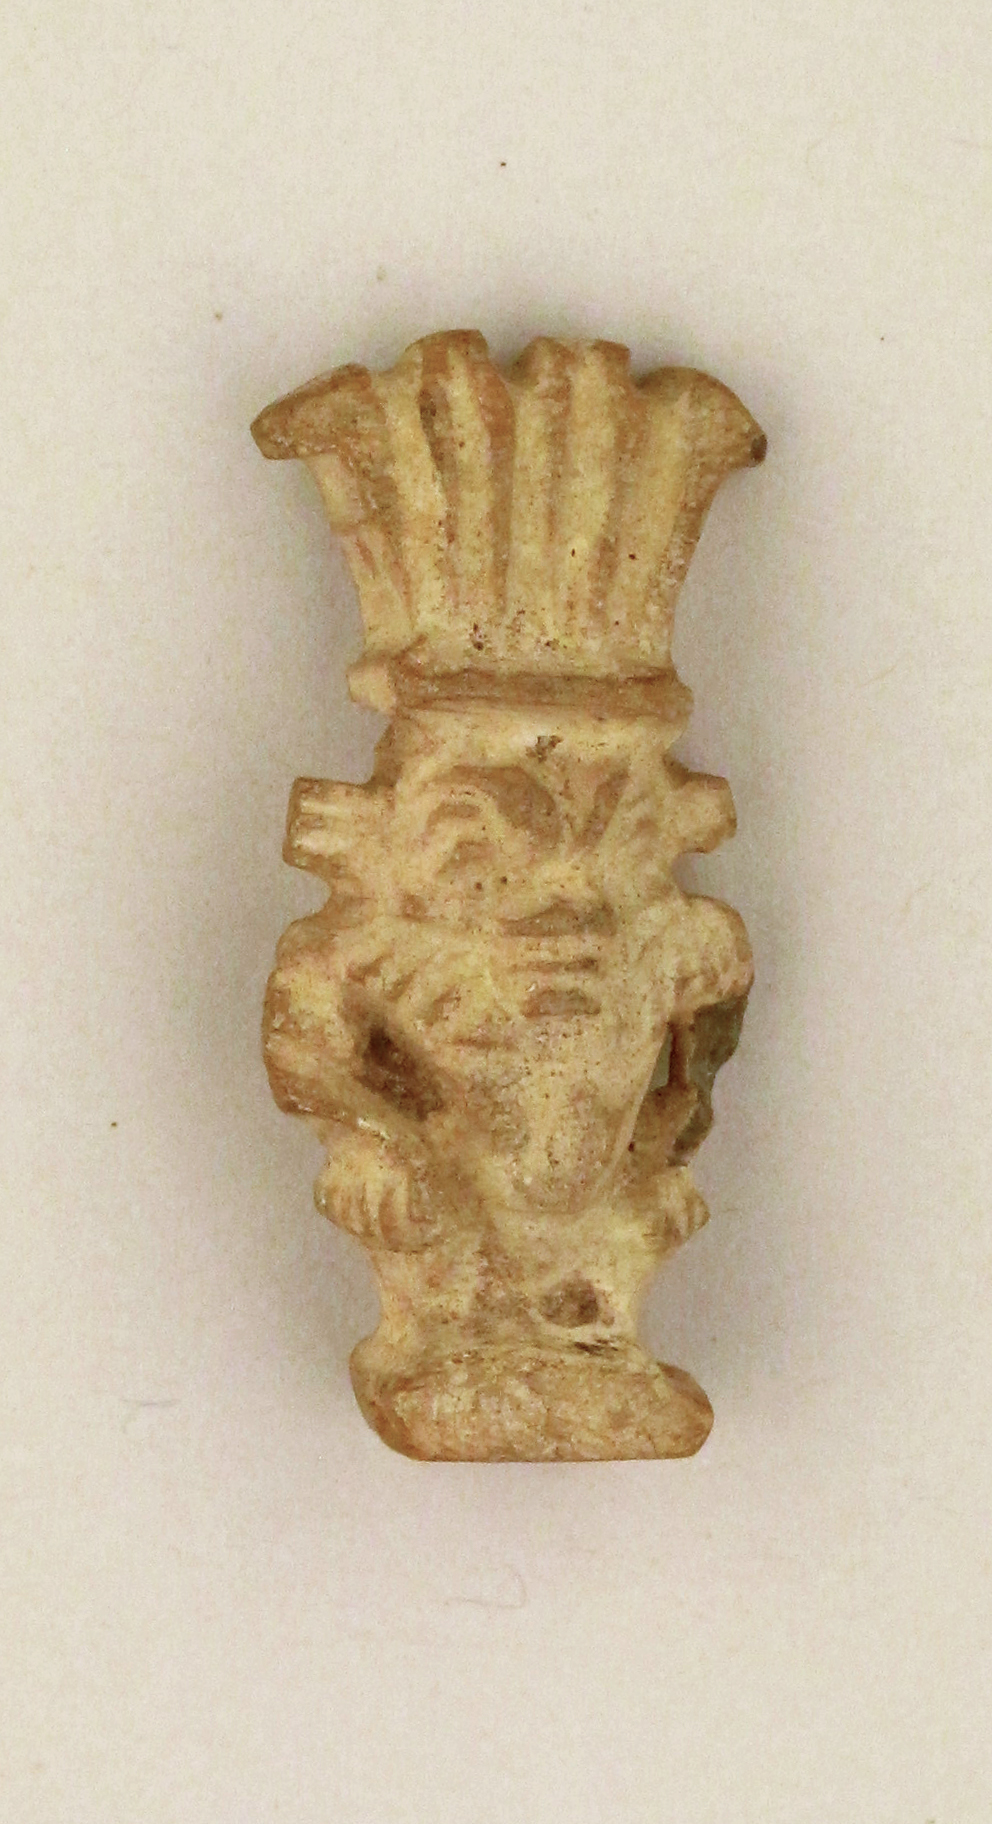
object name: amulet, be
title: Faience amulet of a Bes image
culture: egyptian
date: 330-30 BCE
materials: faience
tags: bes